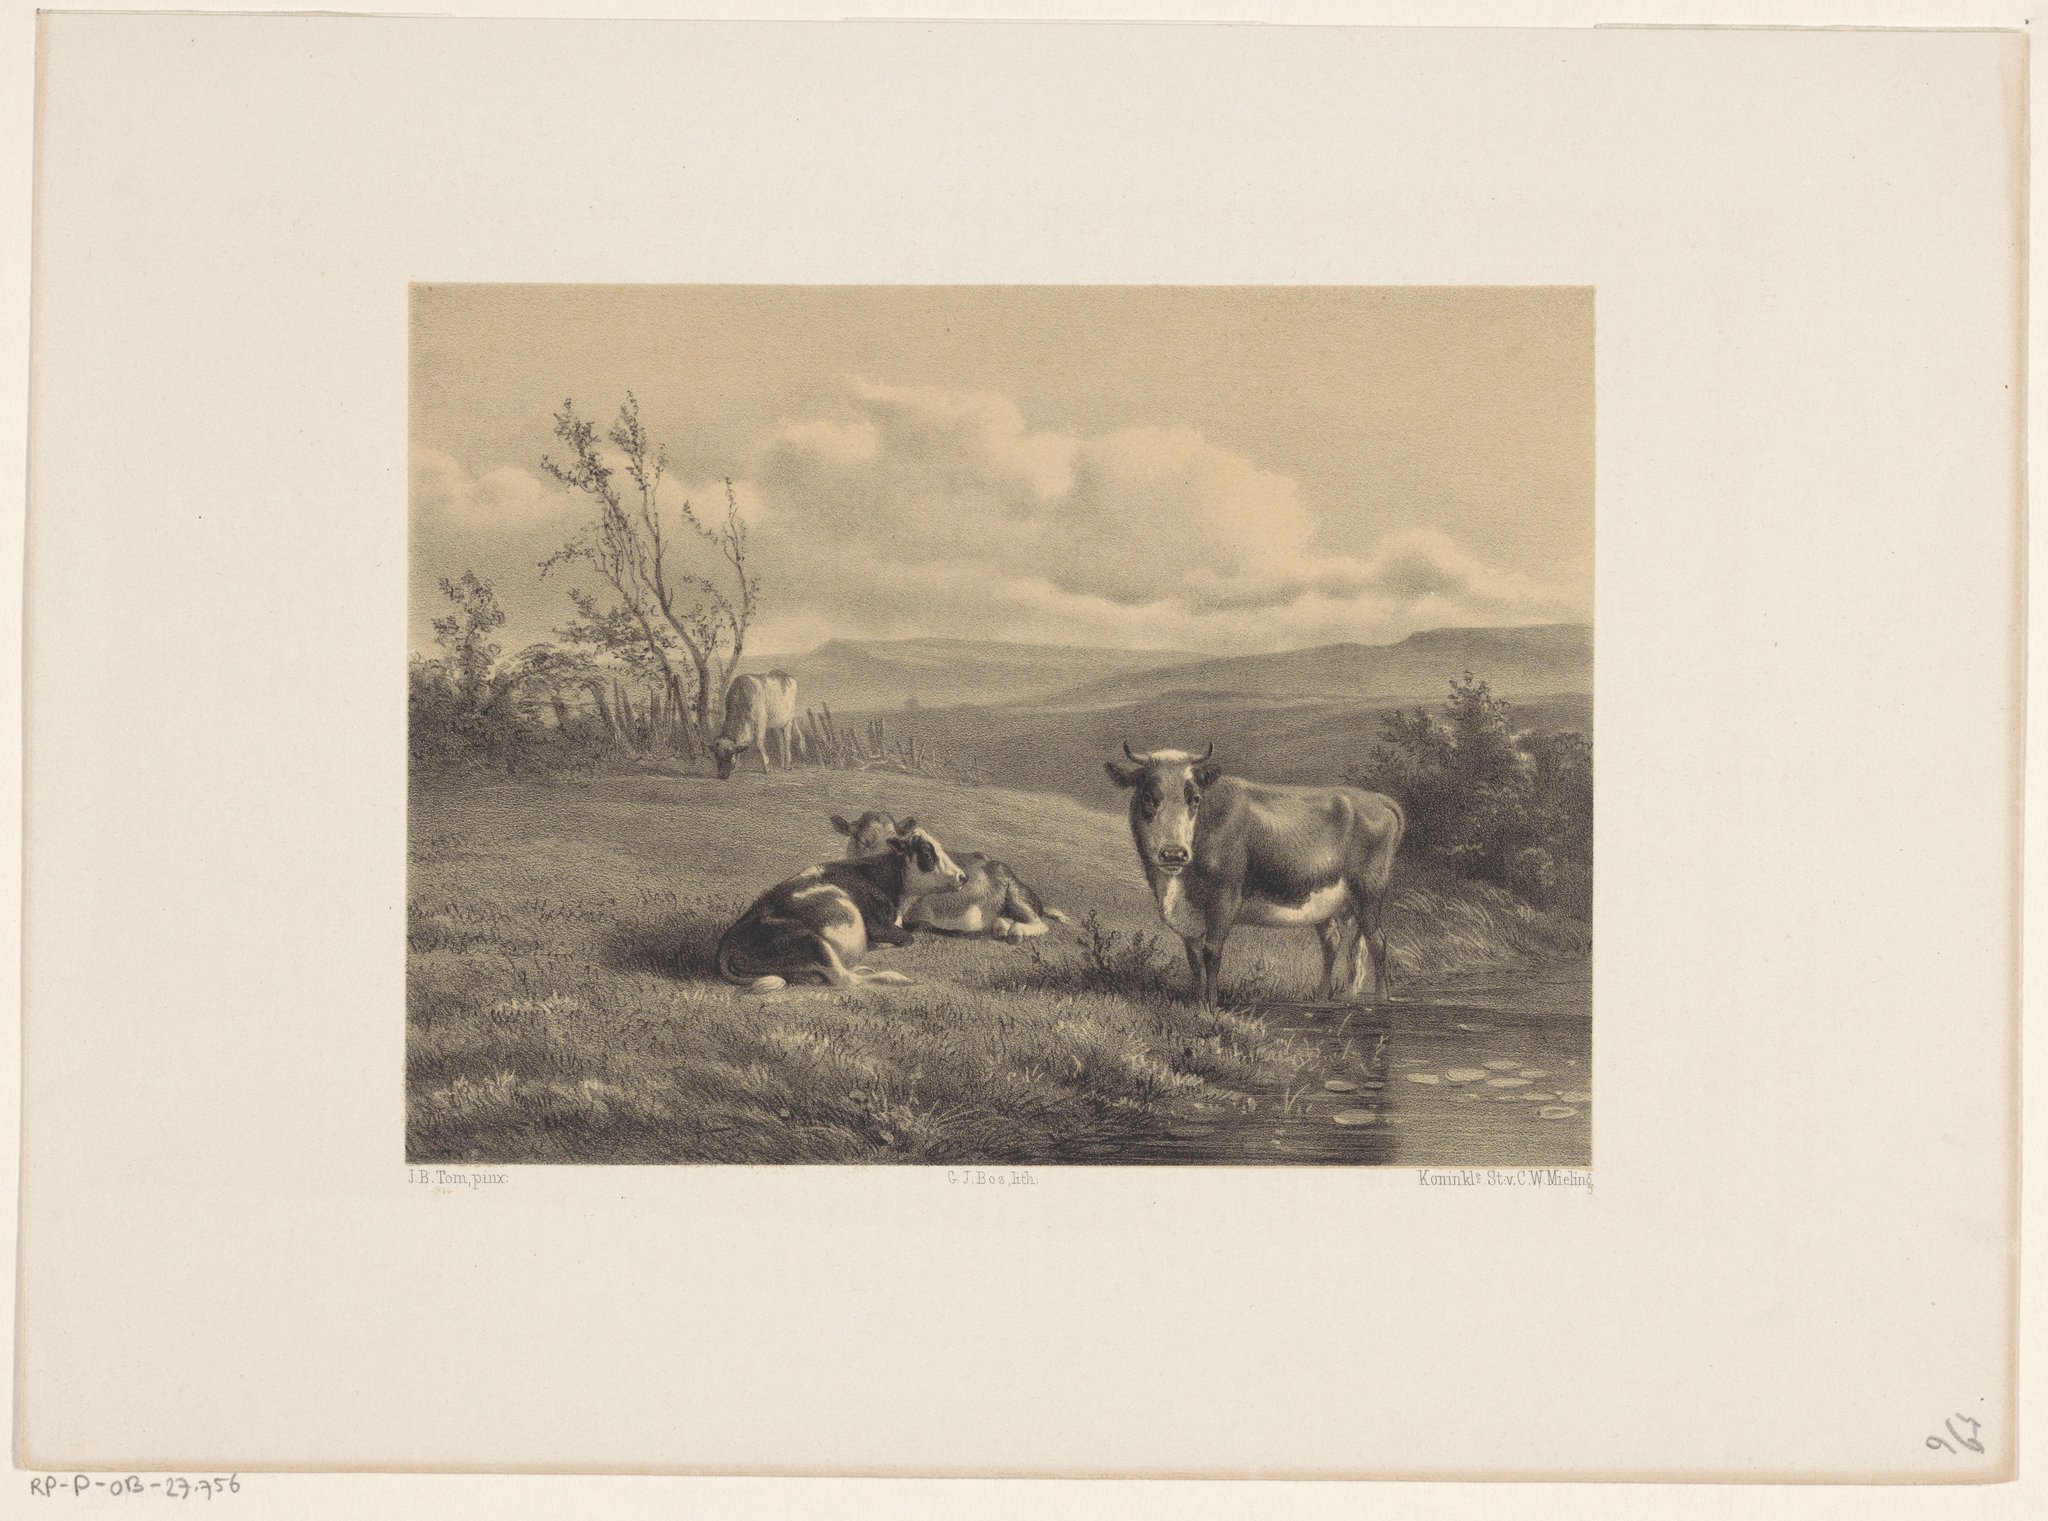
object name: print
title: Koeien aan het water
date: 1835-1898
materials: paper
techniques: tone lithography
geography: netherlands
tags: cow, meadow, pasture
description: Een koe staat half in het water. Twee koeien liggen in het gras en een vierde koe staat verderop bij een hek. Naar een schilderij van Jan Bedijs Tom.